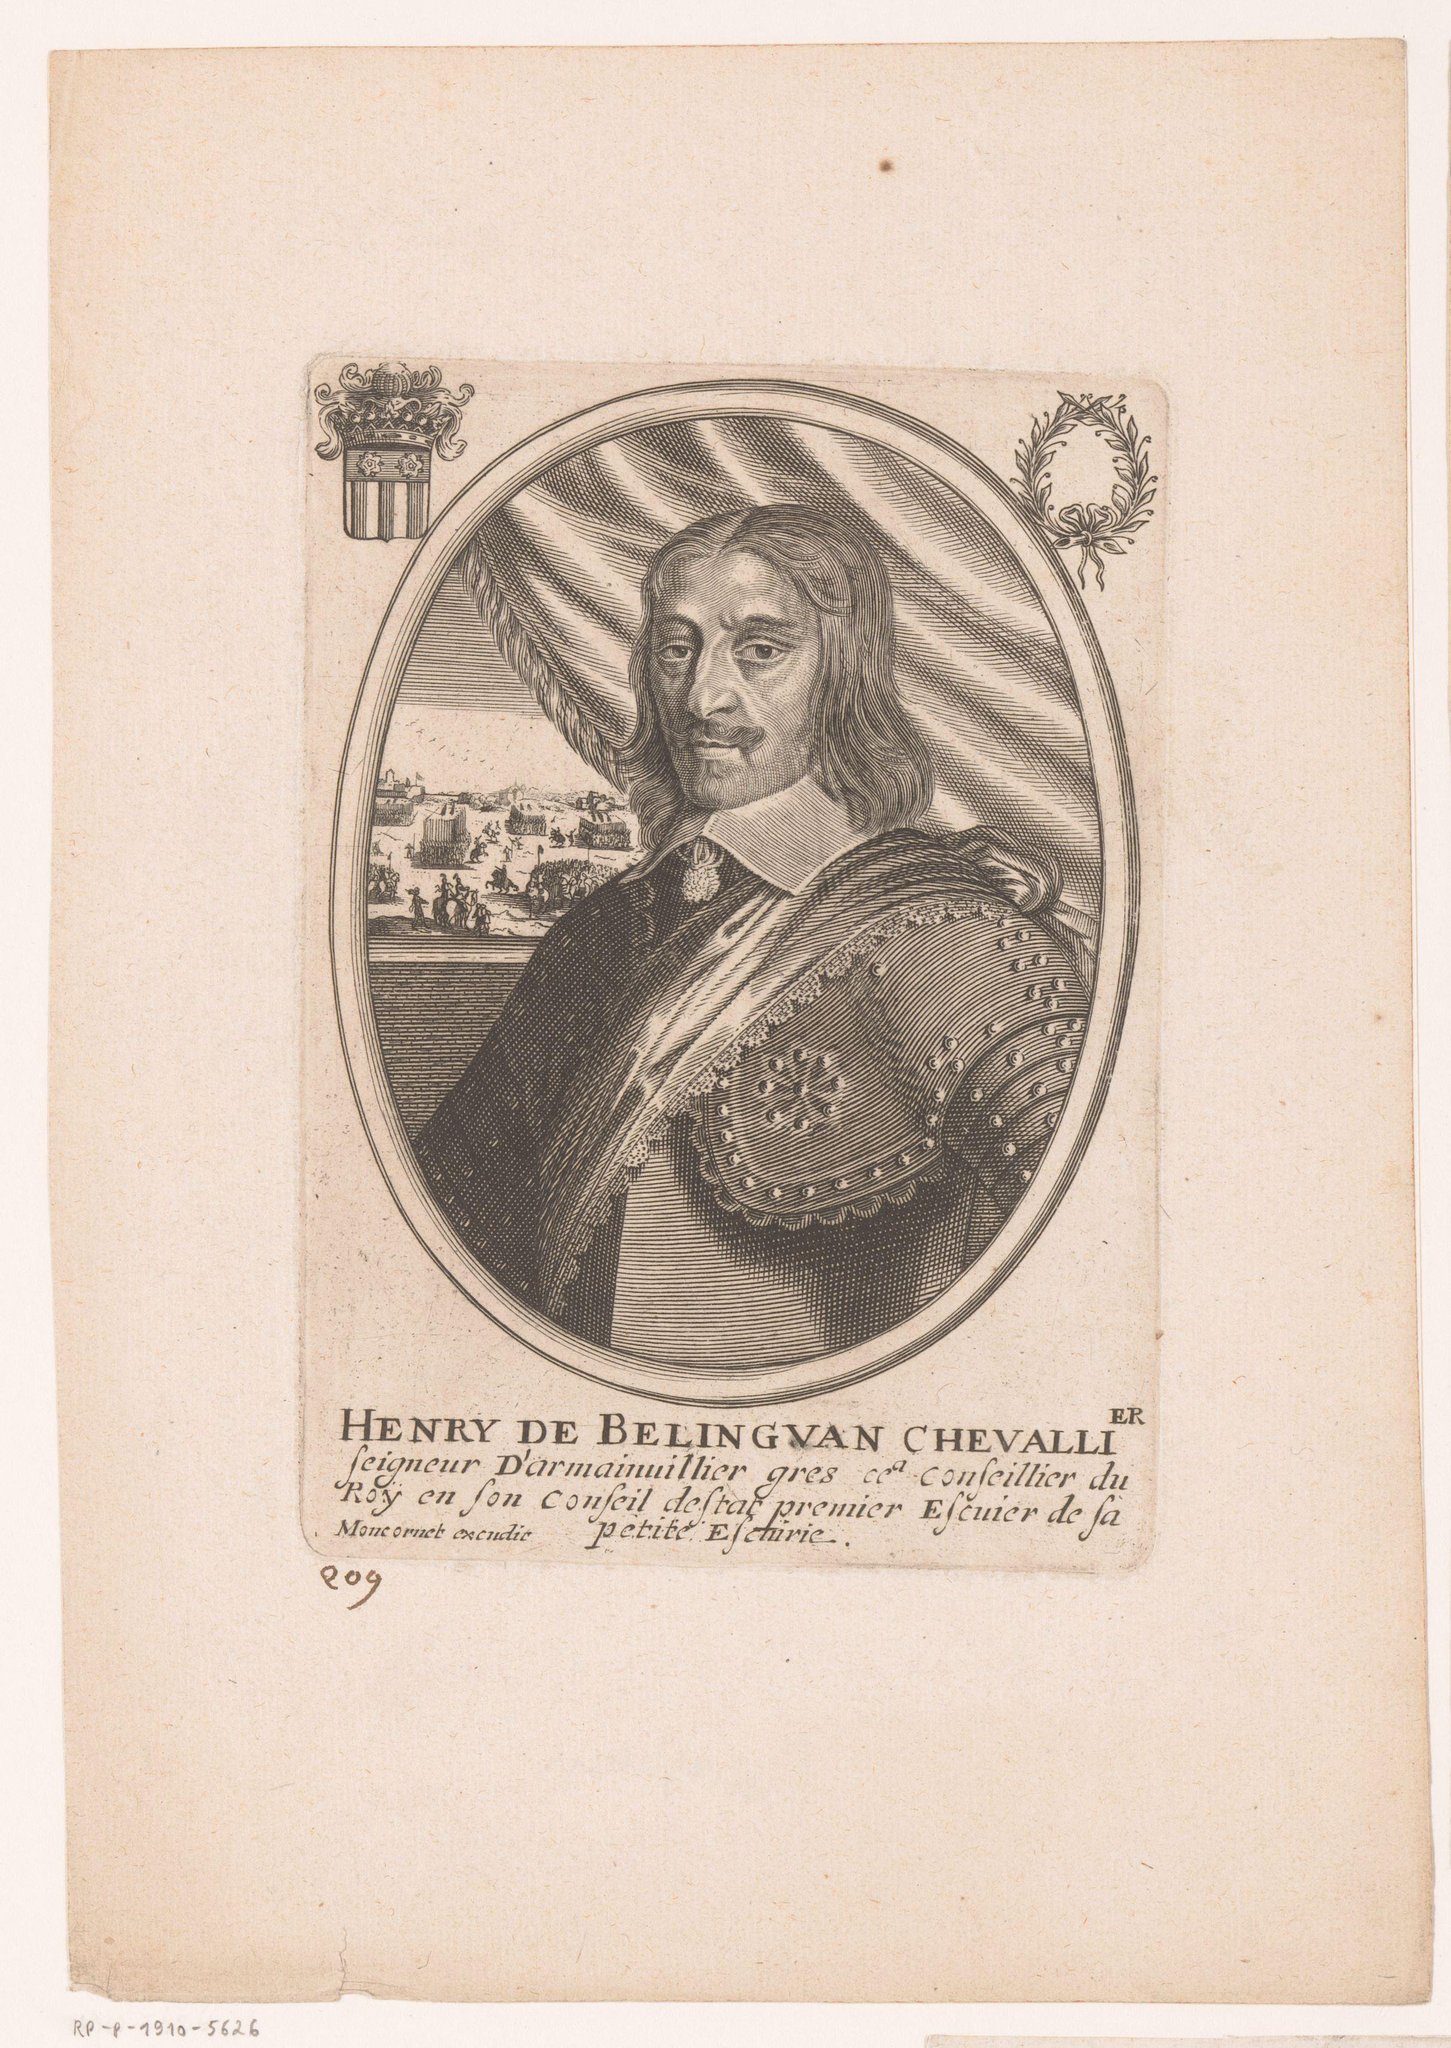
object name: print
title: Portret van Henry de Belingvan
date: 1661-1700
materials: paper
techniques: engraving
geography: paris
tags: historical persons, armorial bearing, heraldry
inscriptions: collector's mark: Lugt 2228, number: ‘209’